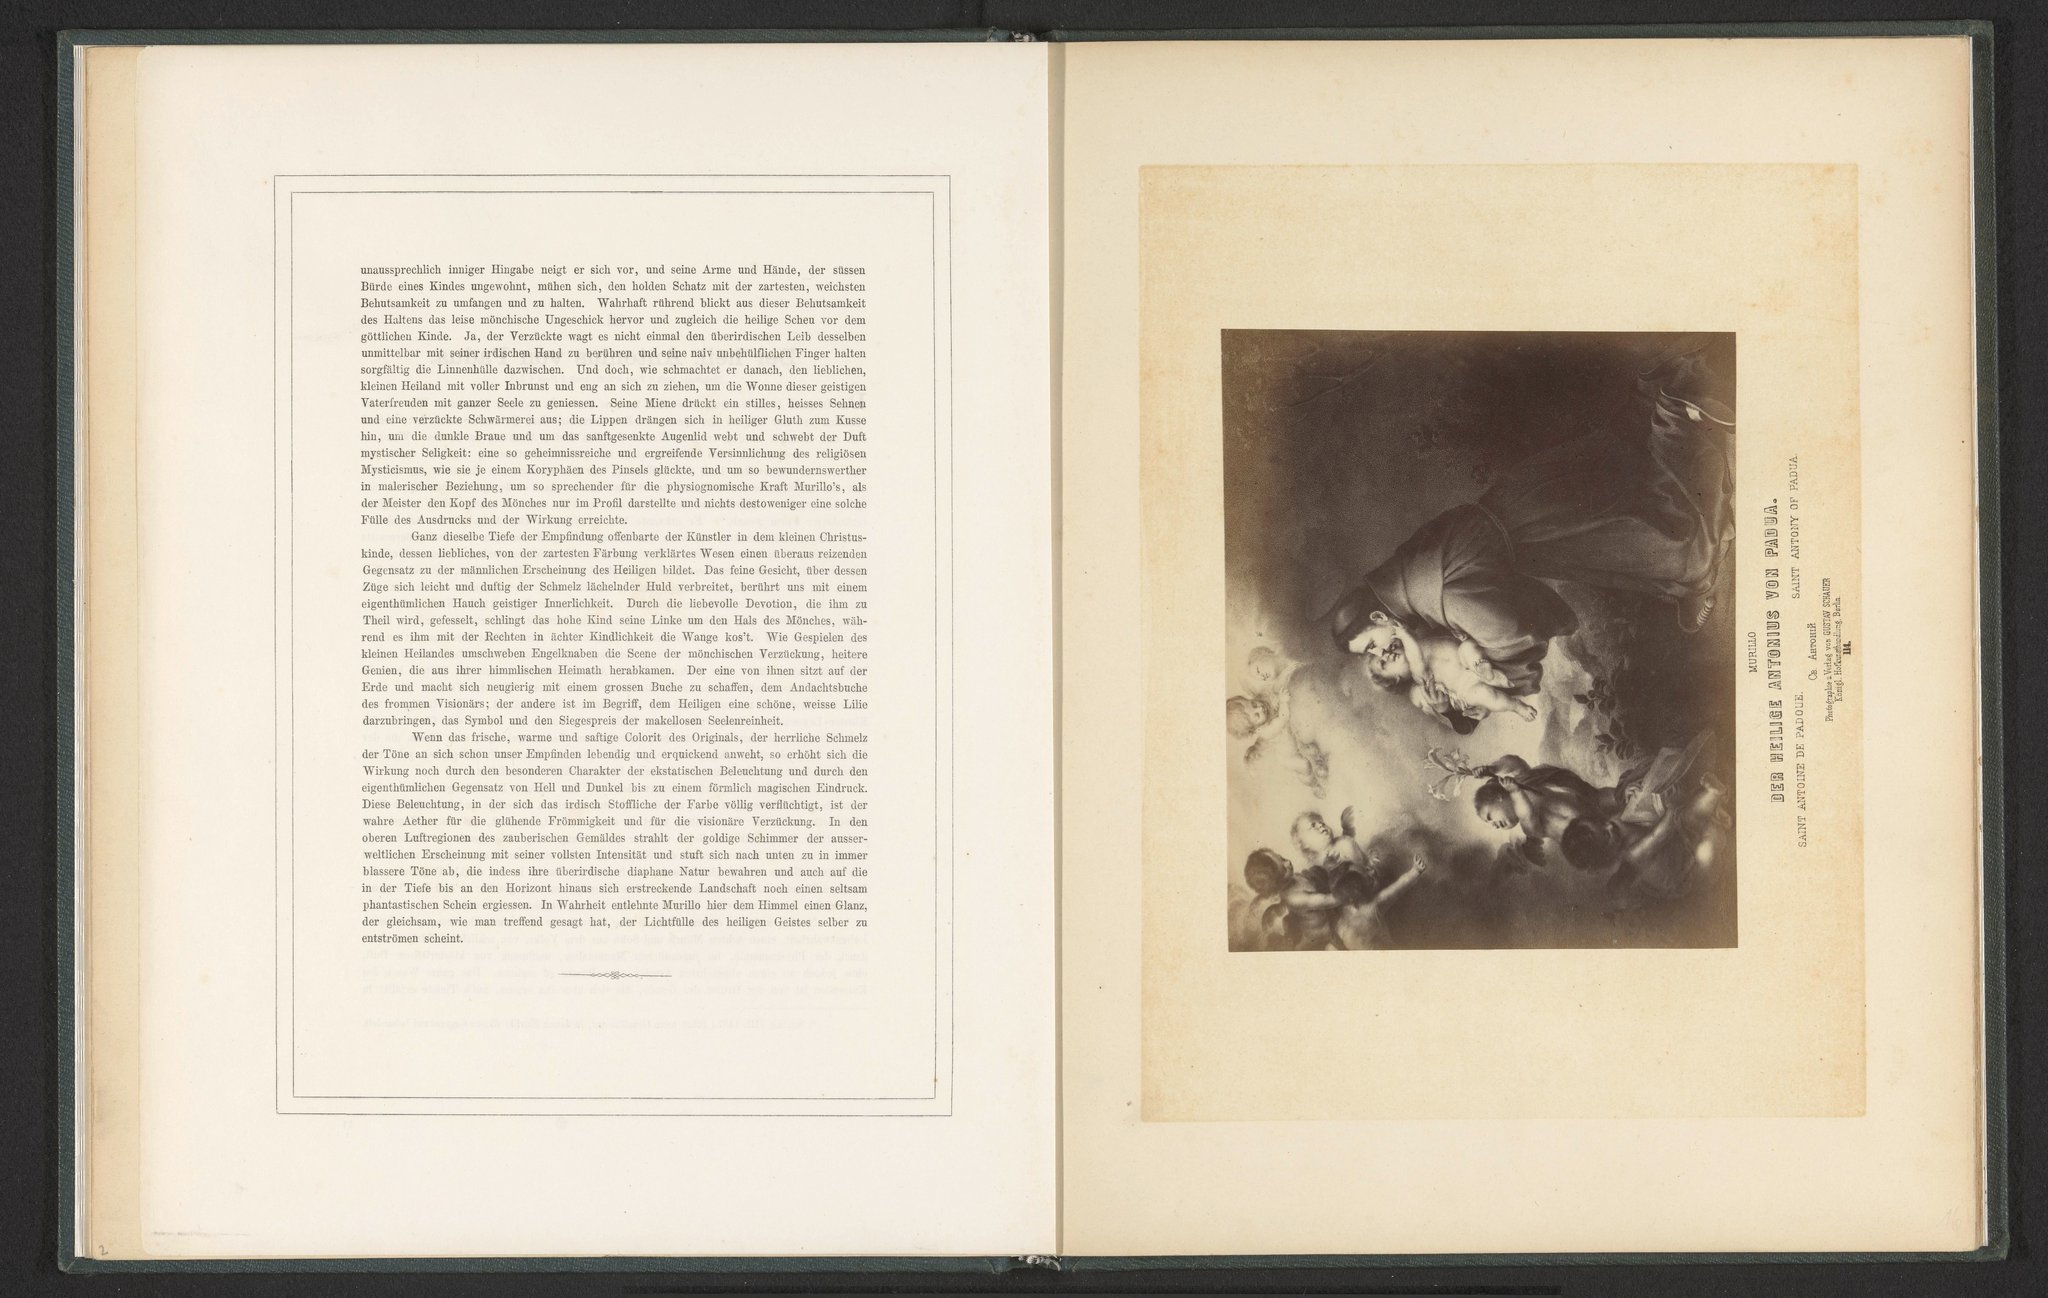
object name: photograph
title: Der heilige Antonius von Padua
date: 1850-1860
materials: photographic support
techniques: albumen print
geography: berlin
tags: the franciscan monk antony of padua; possible attributes: ass, book, crucifix, flowered cross, flaming heart, infant christ (on book), lily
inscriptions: number: ‘114.’